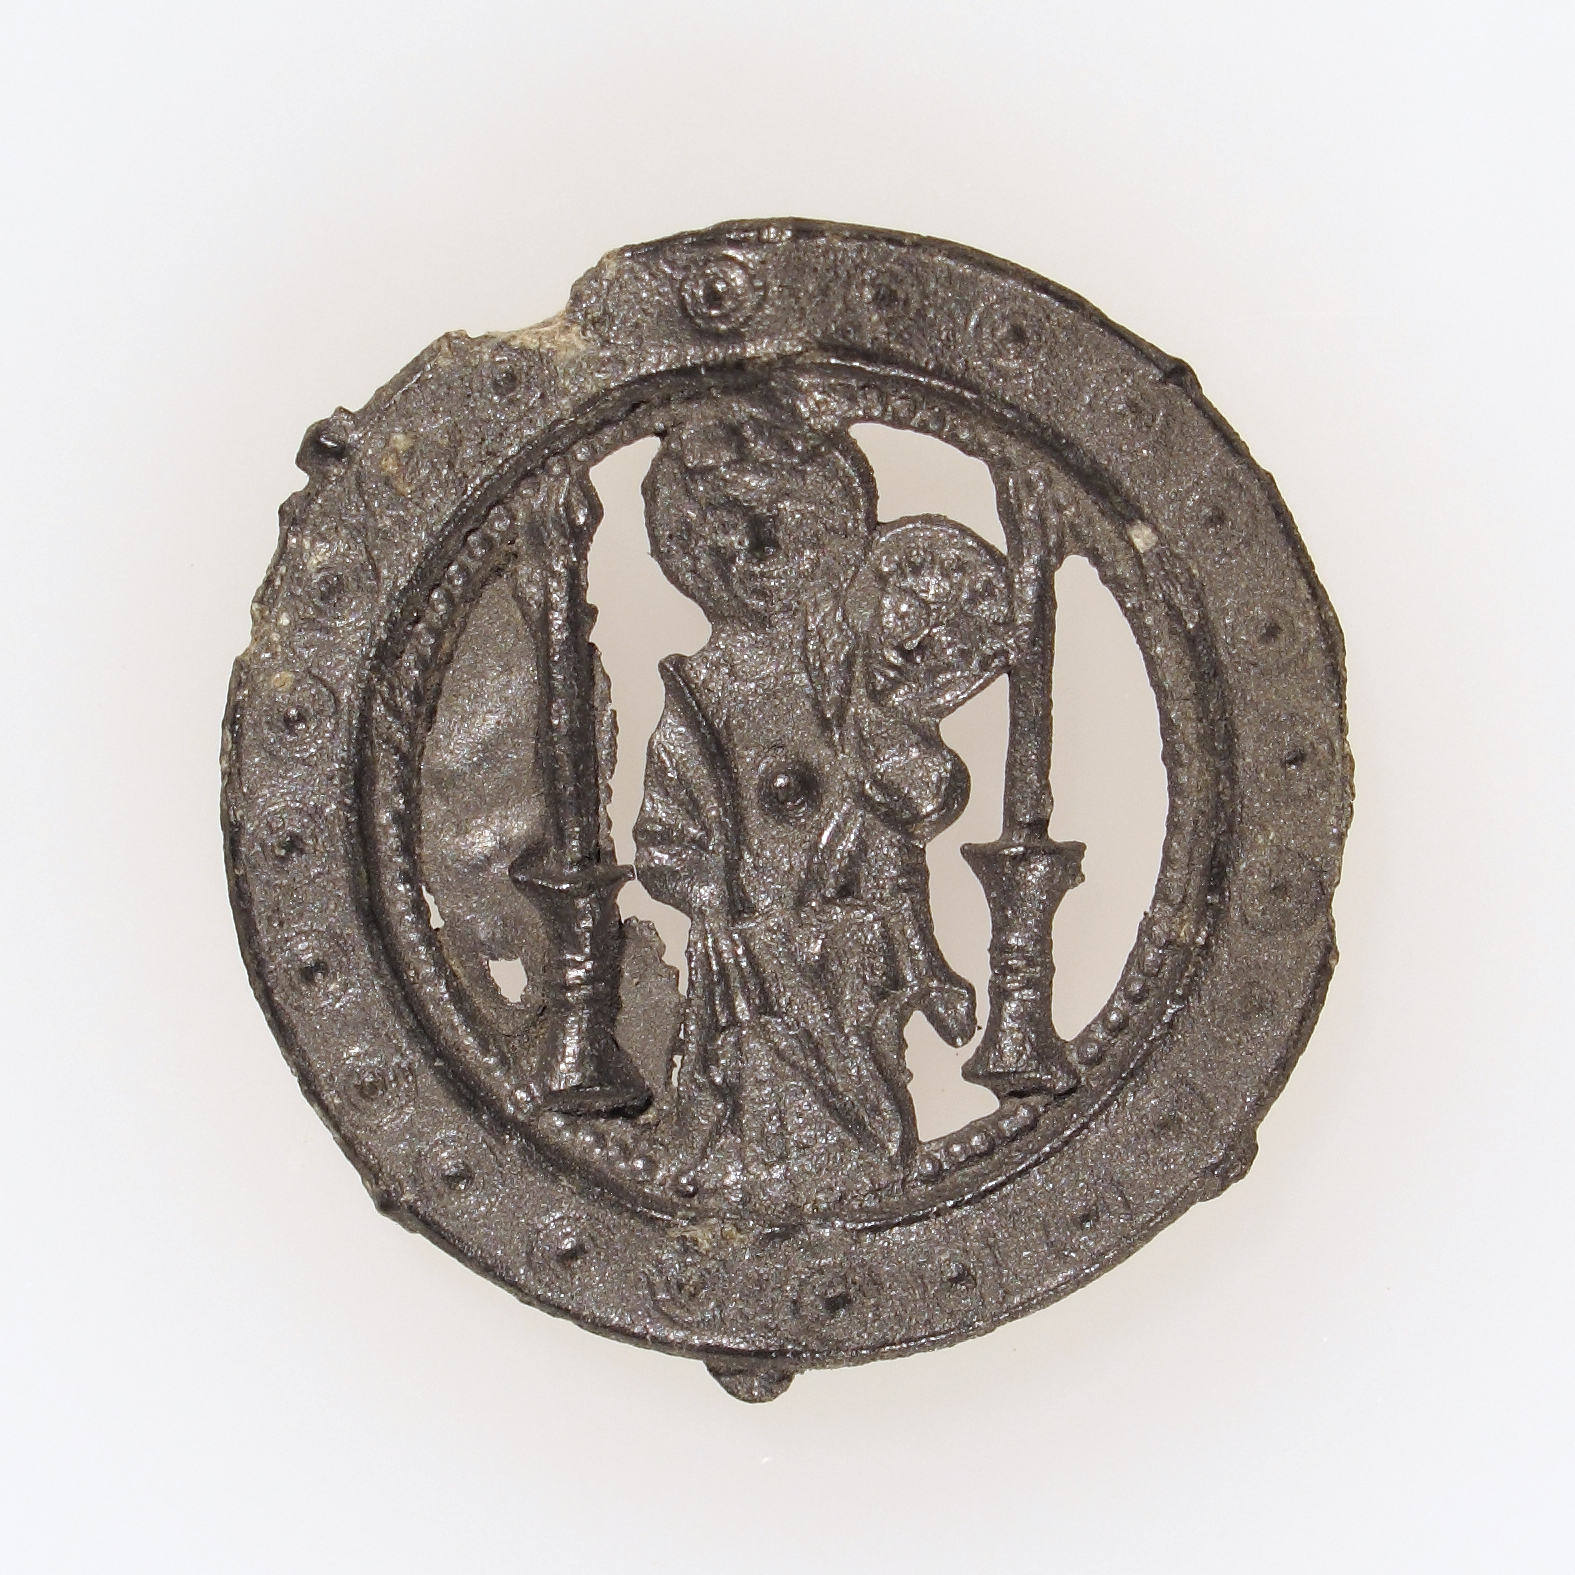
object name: pilgrim's badge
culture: french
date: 1301-1600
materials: lead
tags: madonna and child